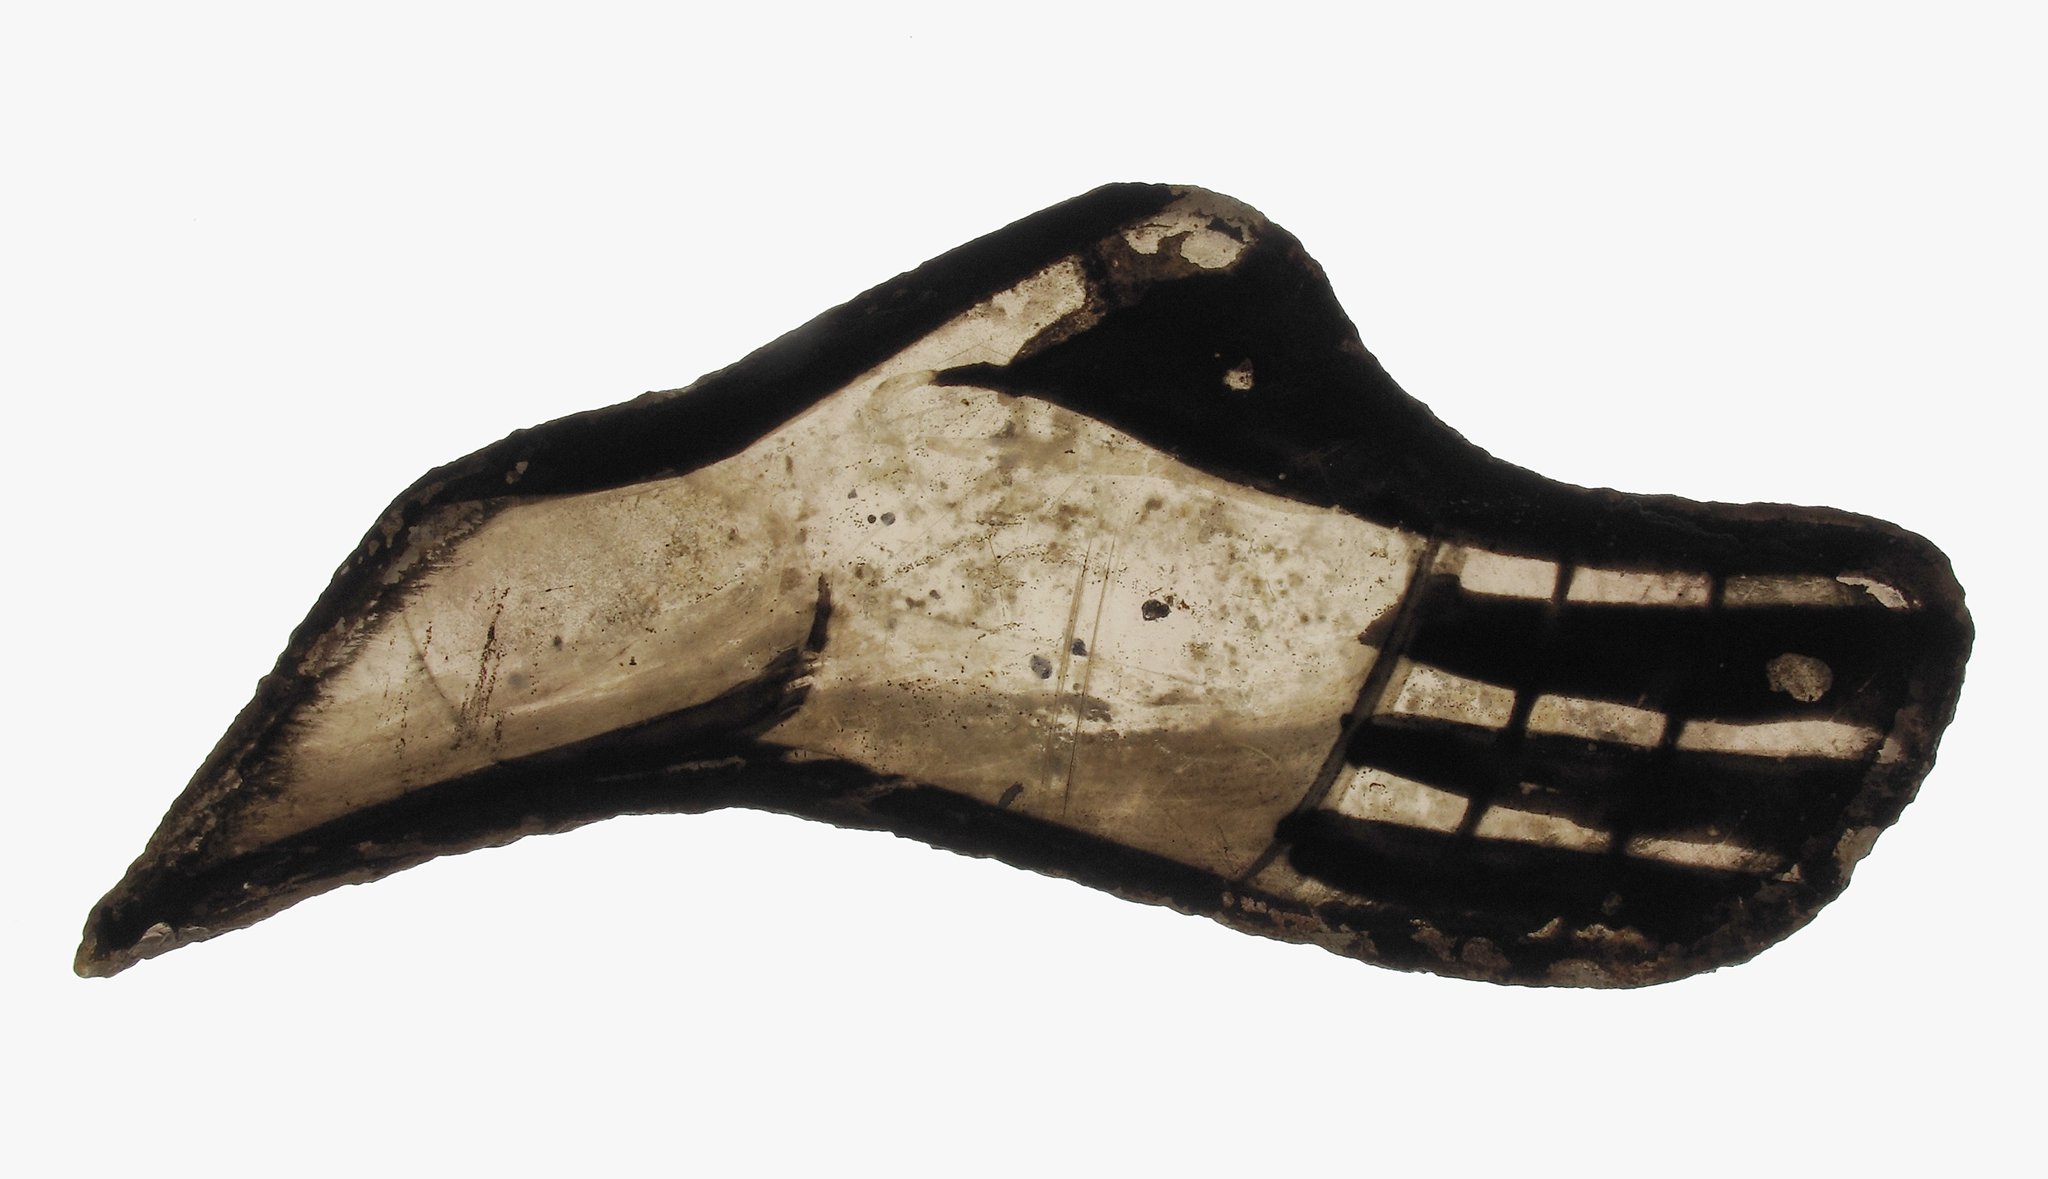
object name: fragment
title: Glass Fragment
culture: european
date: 1201-1400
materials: glass